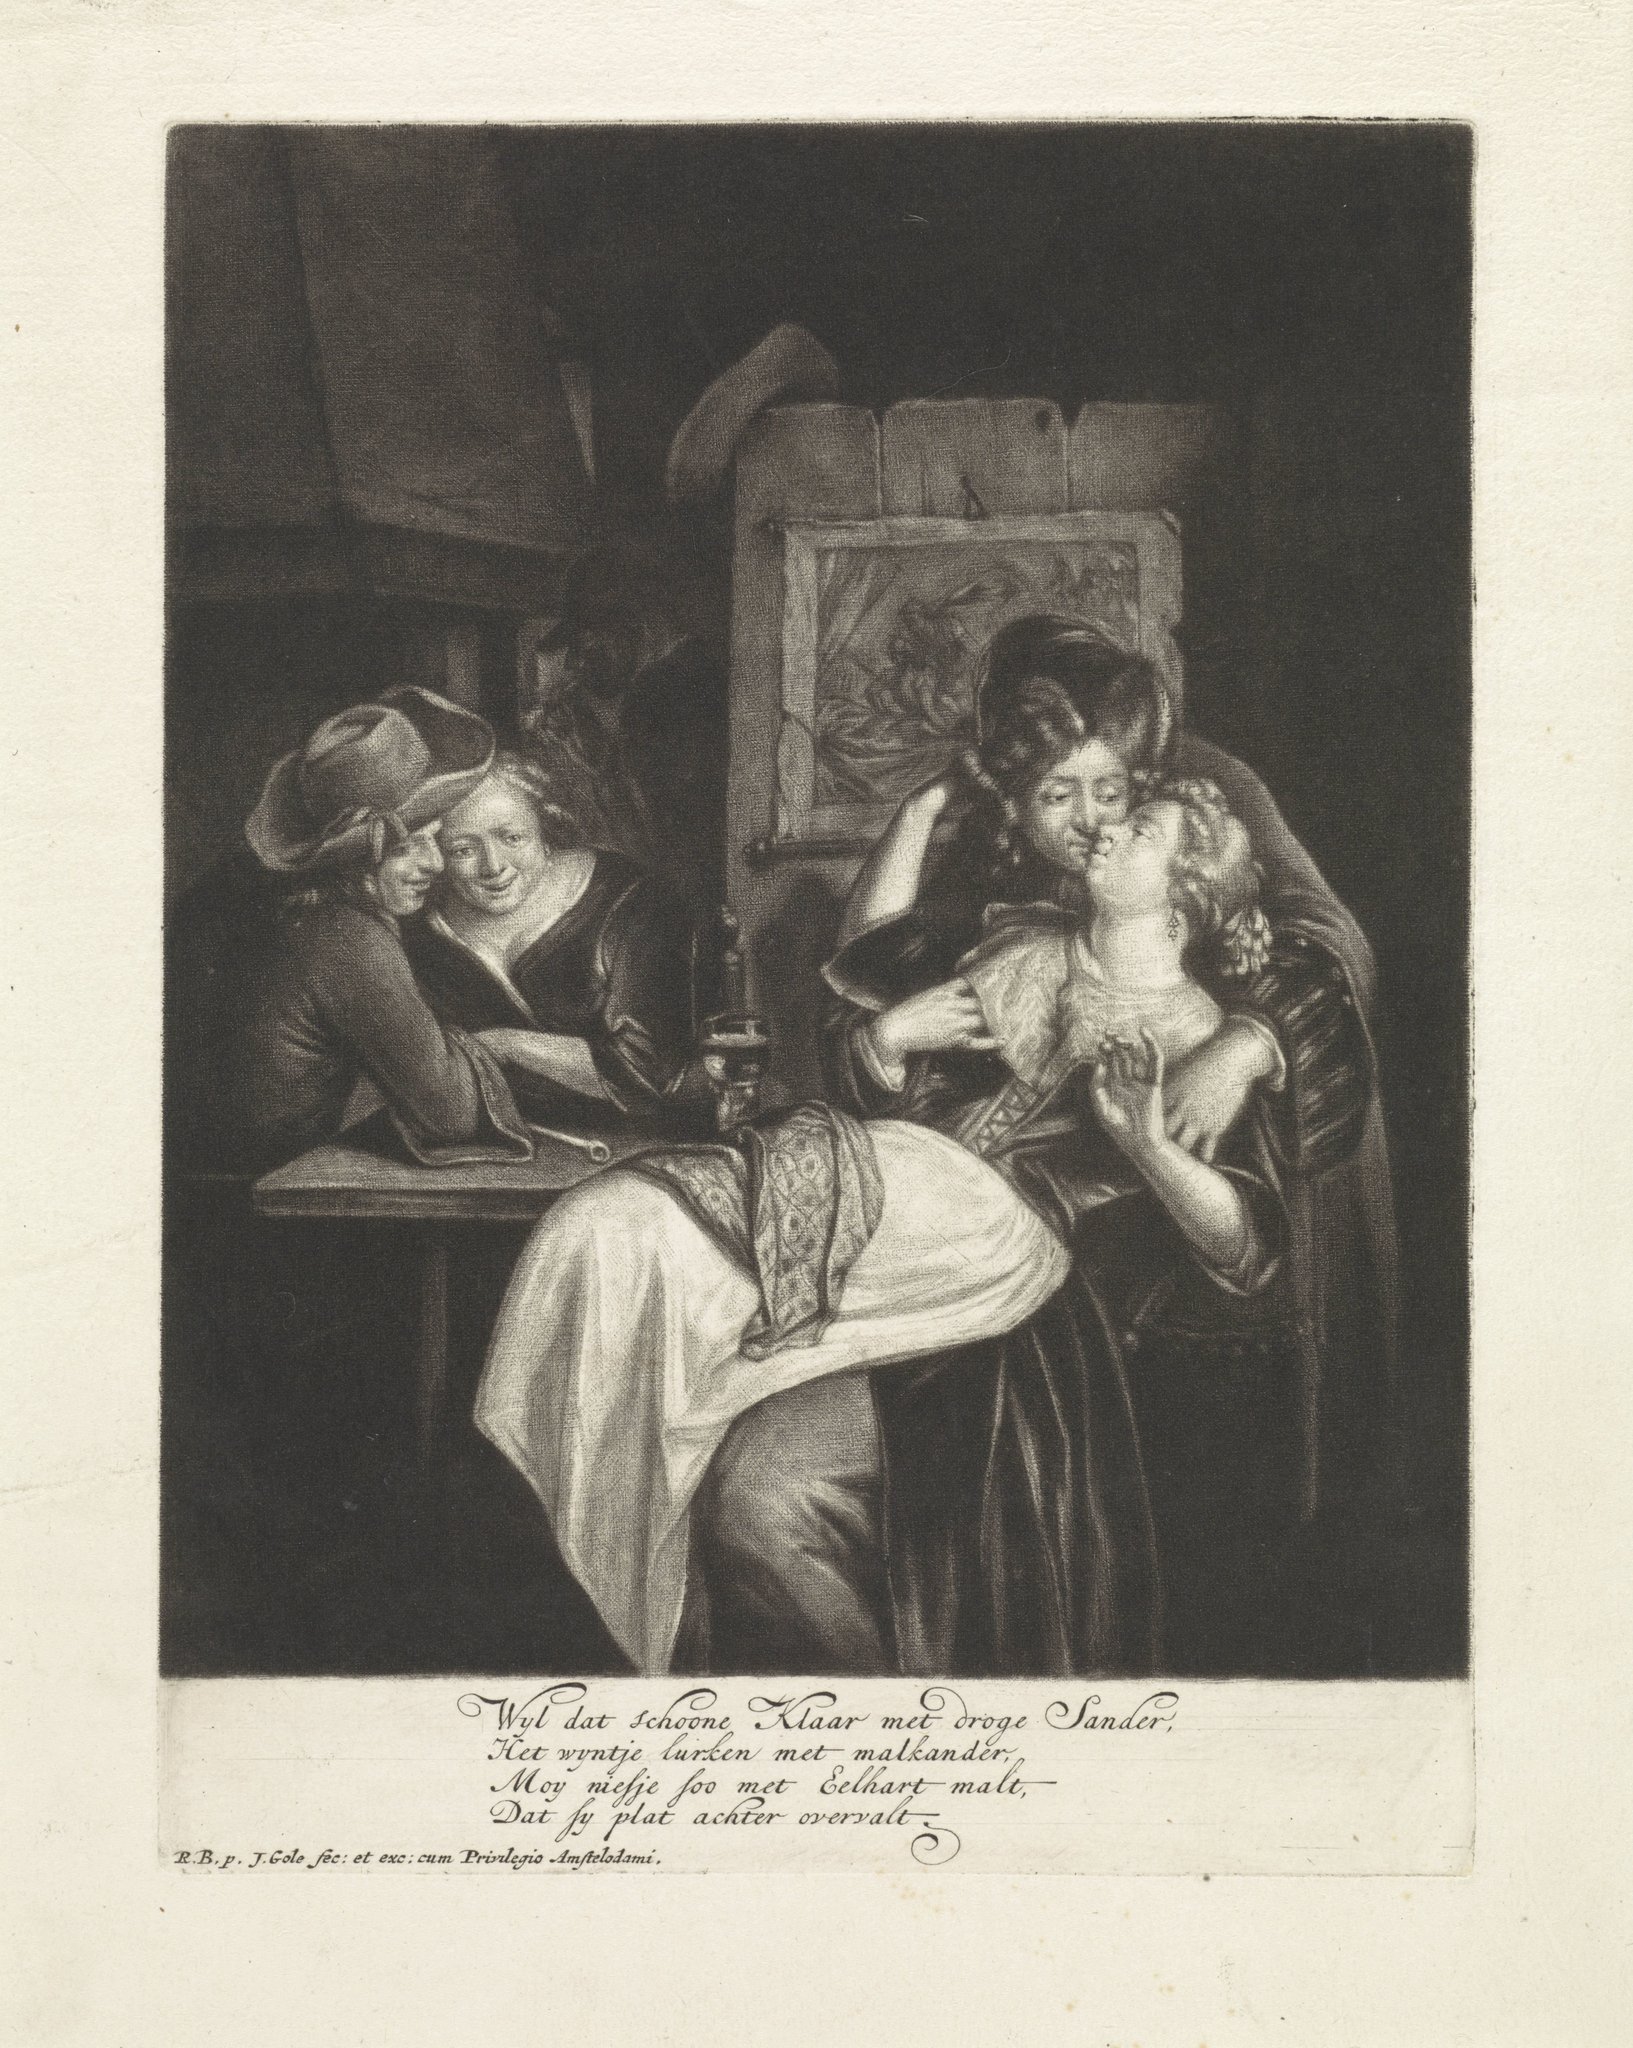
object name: print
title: Twee liefdesparen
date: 1670-1724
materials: paper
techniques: engraving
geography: amsterdam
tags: pipe ~ tobacco, couple of lovers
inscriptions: collector's mark: Lugt 240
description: In een herberg zitten twee liefdesparen bij een tafel. Aan een houten tussenmuur hangt een prent.